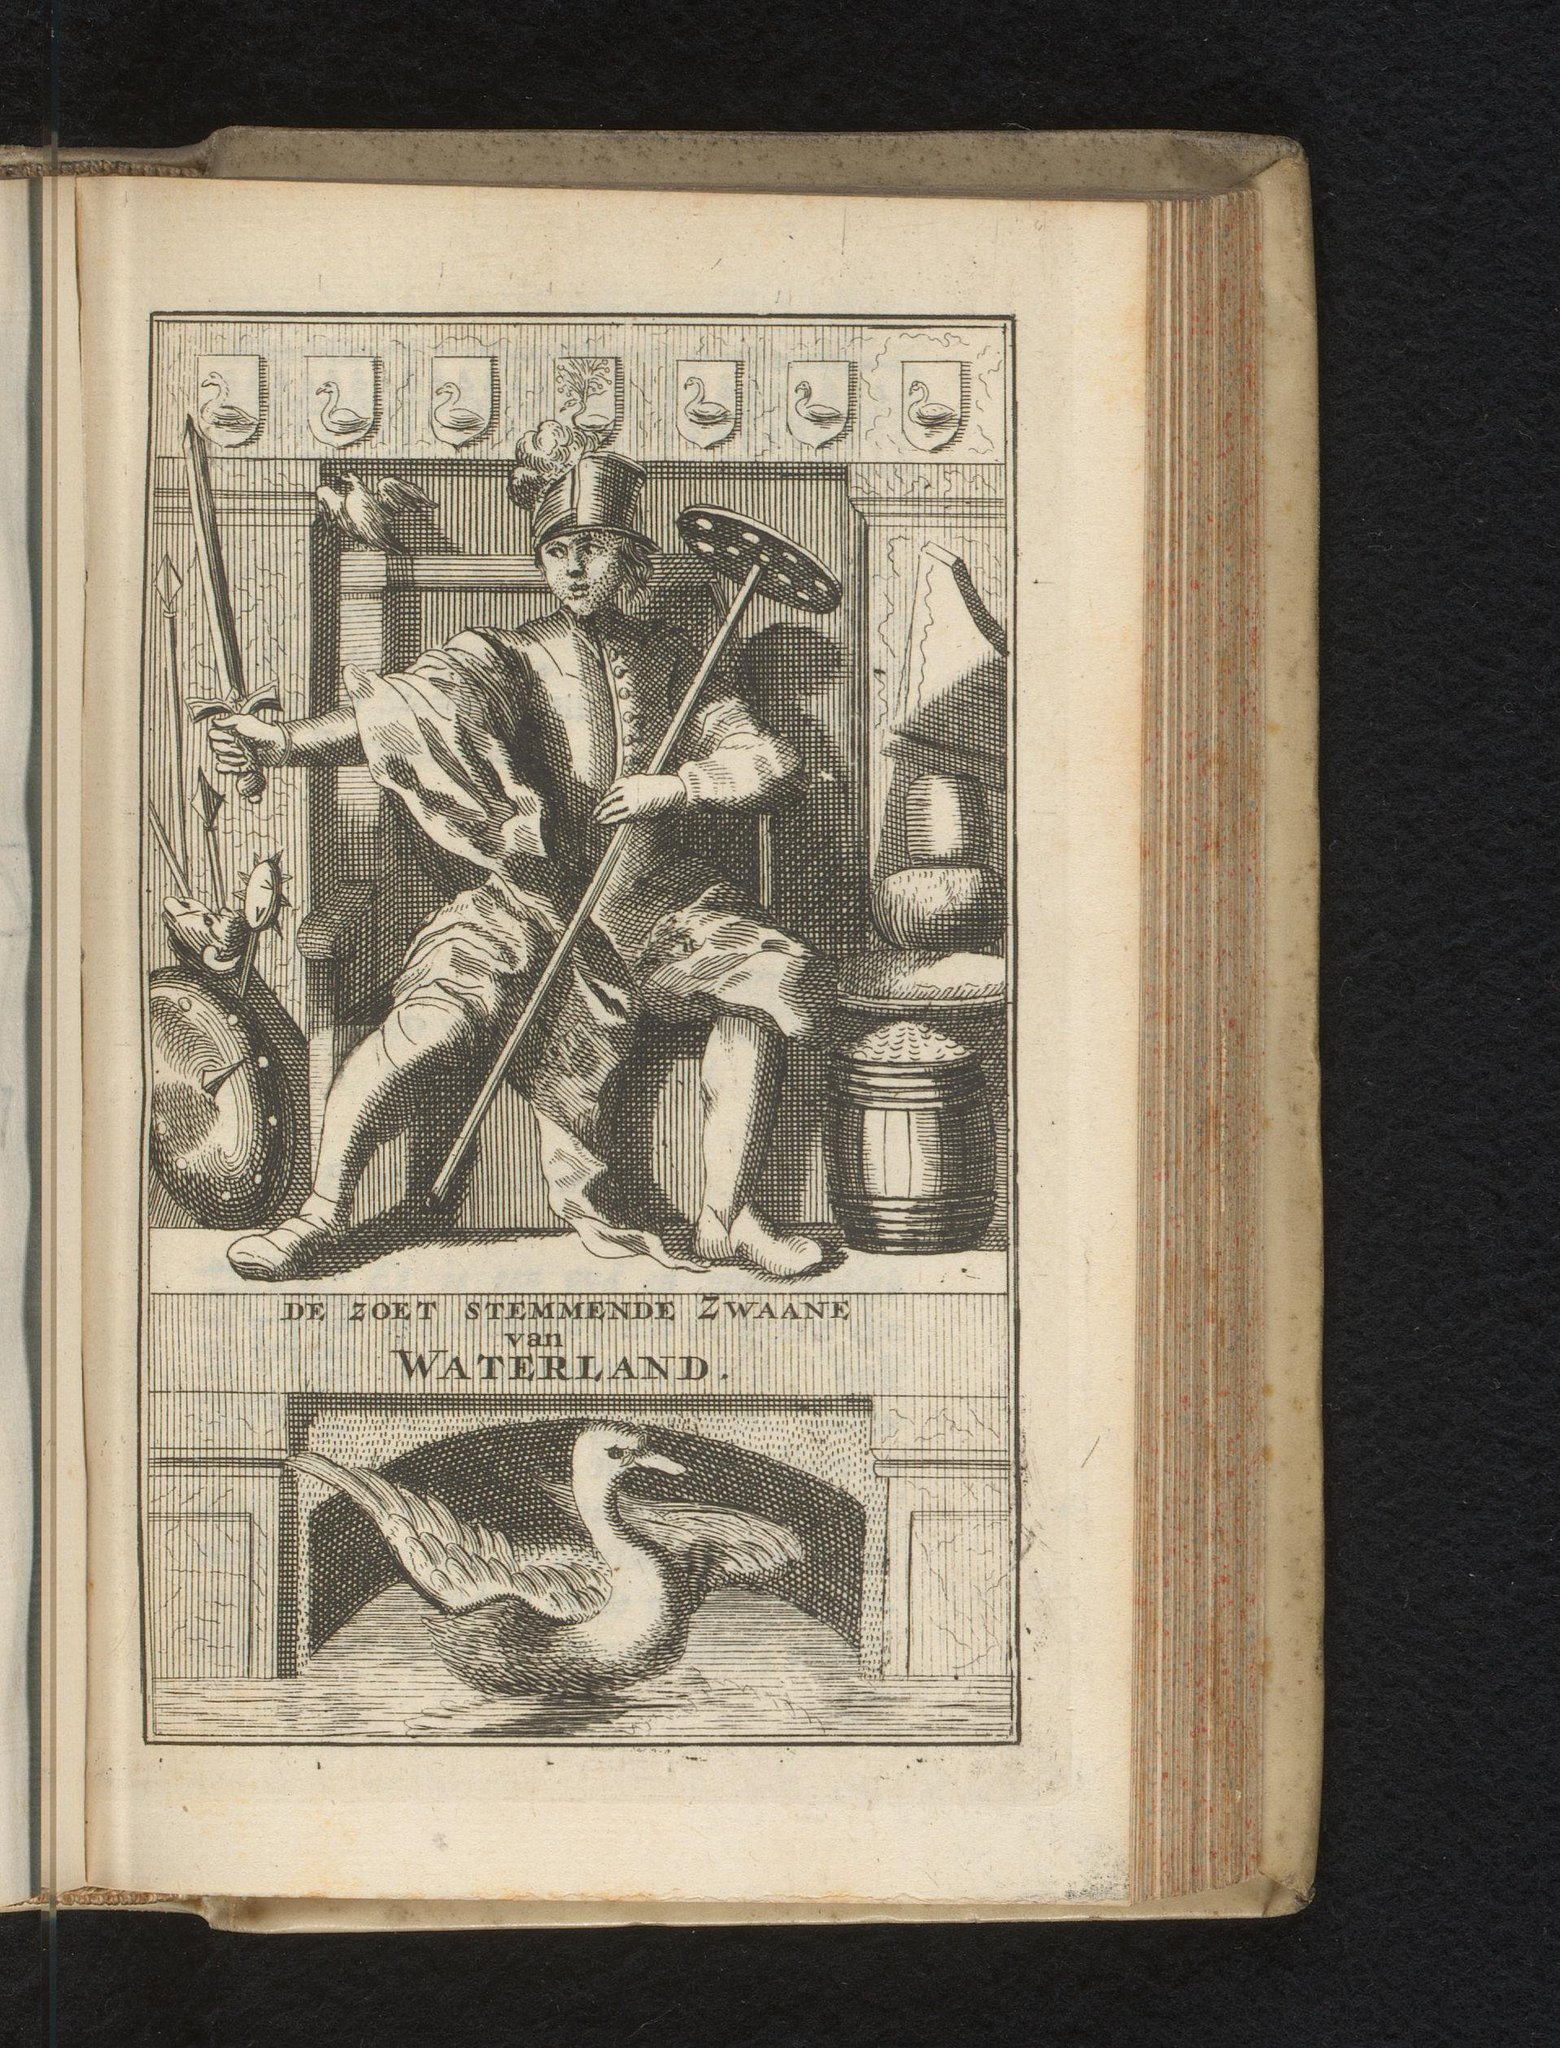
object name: titelprent, frontispice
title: Titelpent voor De soet-stemmende zwaane van Waterland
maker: pieter van den berge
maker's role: draughtsman, print maker, printer, publisher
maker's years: 1659-1737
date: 1700-1702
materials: paper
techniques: etching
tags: water-birds: swan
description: Illustratie in: H. Soeteboom, Oud-heden van Zaan-land, Stavoren, Vronen en Waterland : deze laatste druk ... met nodige aanteekeningen, figuren, en een landkaart verrykt / De soet-stemmende zwaane van Waterland, W. Linnig van Koppenol, Amsterdam 1702, titelprent.